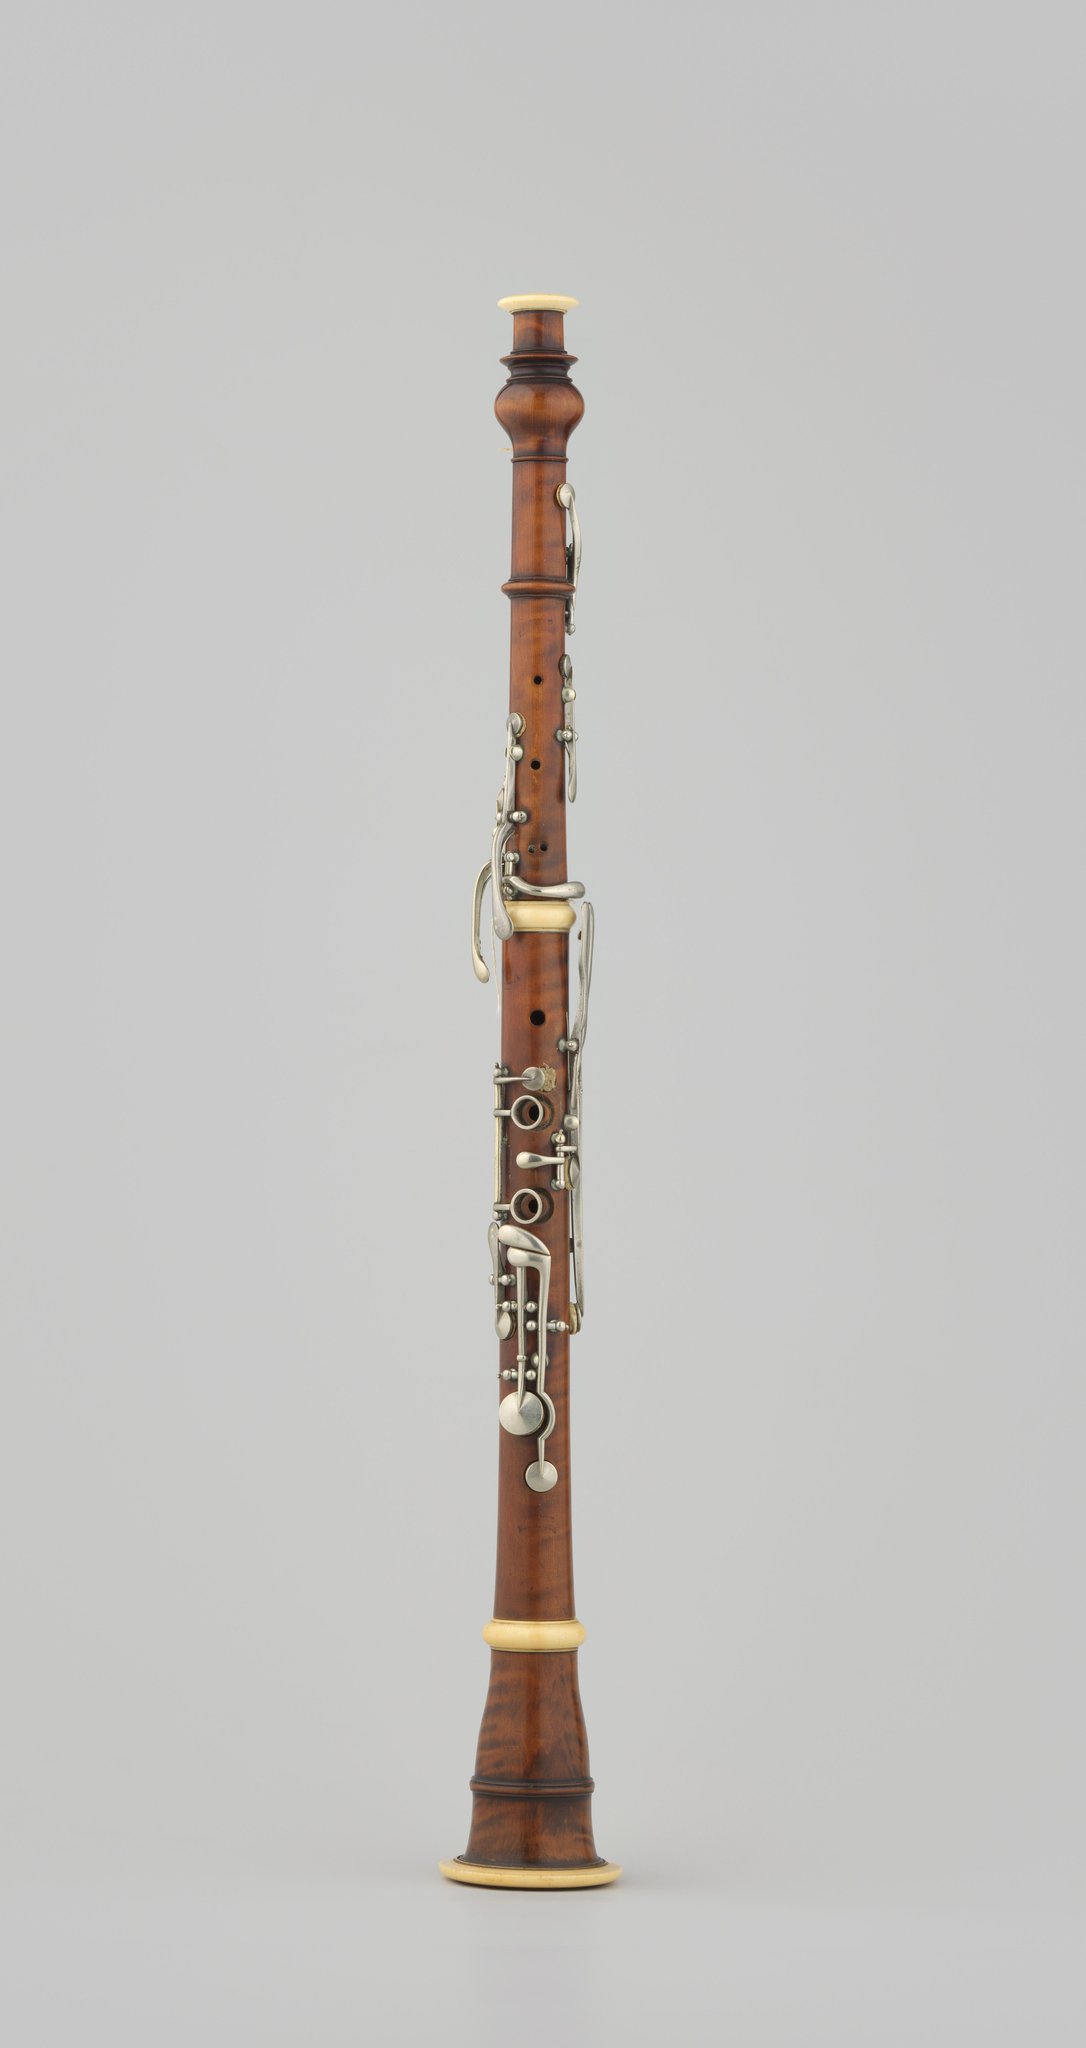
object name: wind instrument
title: Oboe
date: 1850-1860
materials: wood, ivory, silver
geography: biebrich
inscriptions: mark: ‘HECKEL (in een boog) / BIEBRICH (in een boog).’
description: Hobo van donkerbruin gebeitst palmhout, bestaande uit vier onderdelen. De hobo heeft twaalf zilveren kleppen met ronde plaatjes, vier ivoren ringen, een zilveren vingersteun en een extra stemstukje om te kunnen wisselen. Het derde gat is dubbel. Het Fis resonans klepje zit aan een stangmechaniekje; dit is later toegevoegd of gerepareerd. Gemarkeerd op alle drie de delen: HECKEL (in een boog) / BIEBRICH (in een boog).